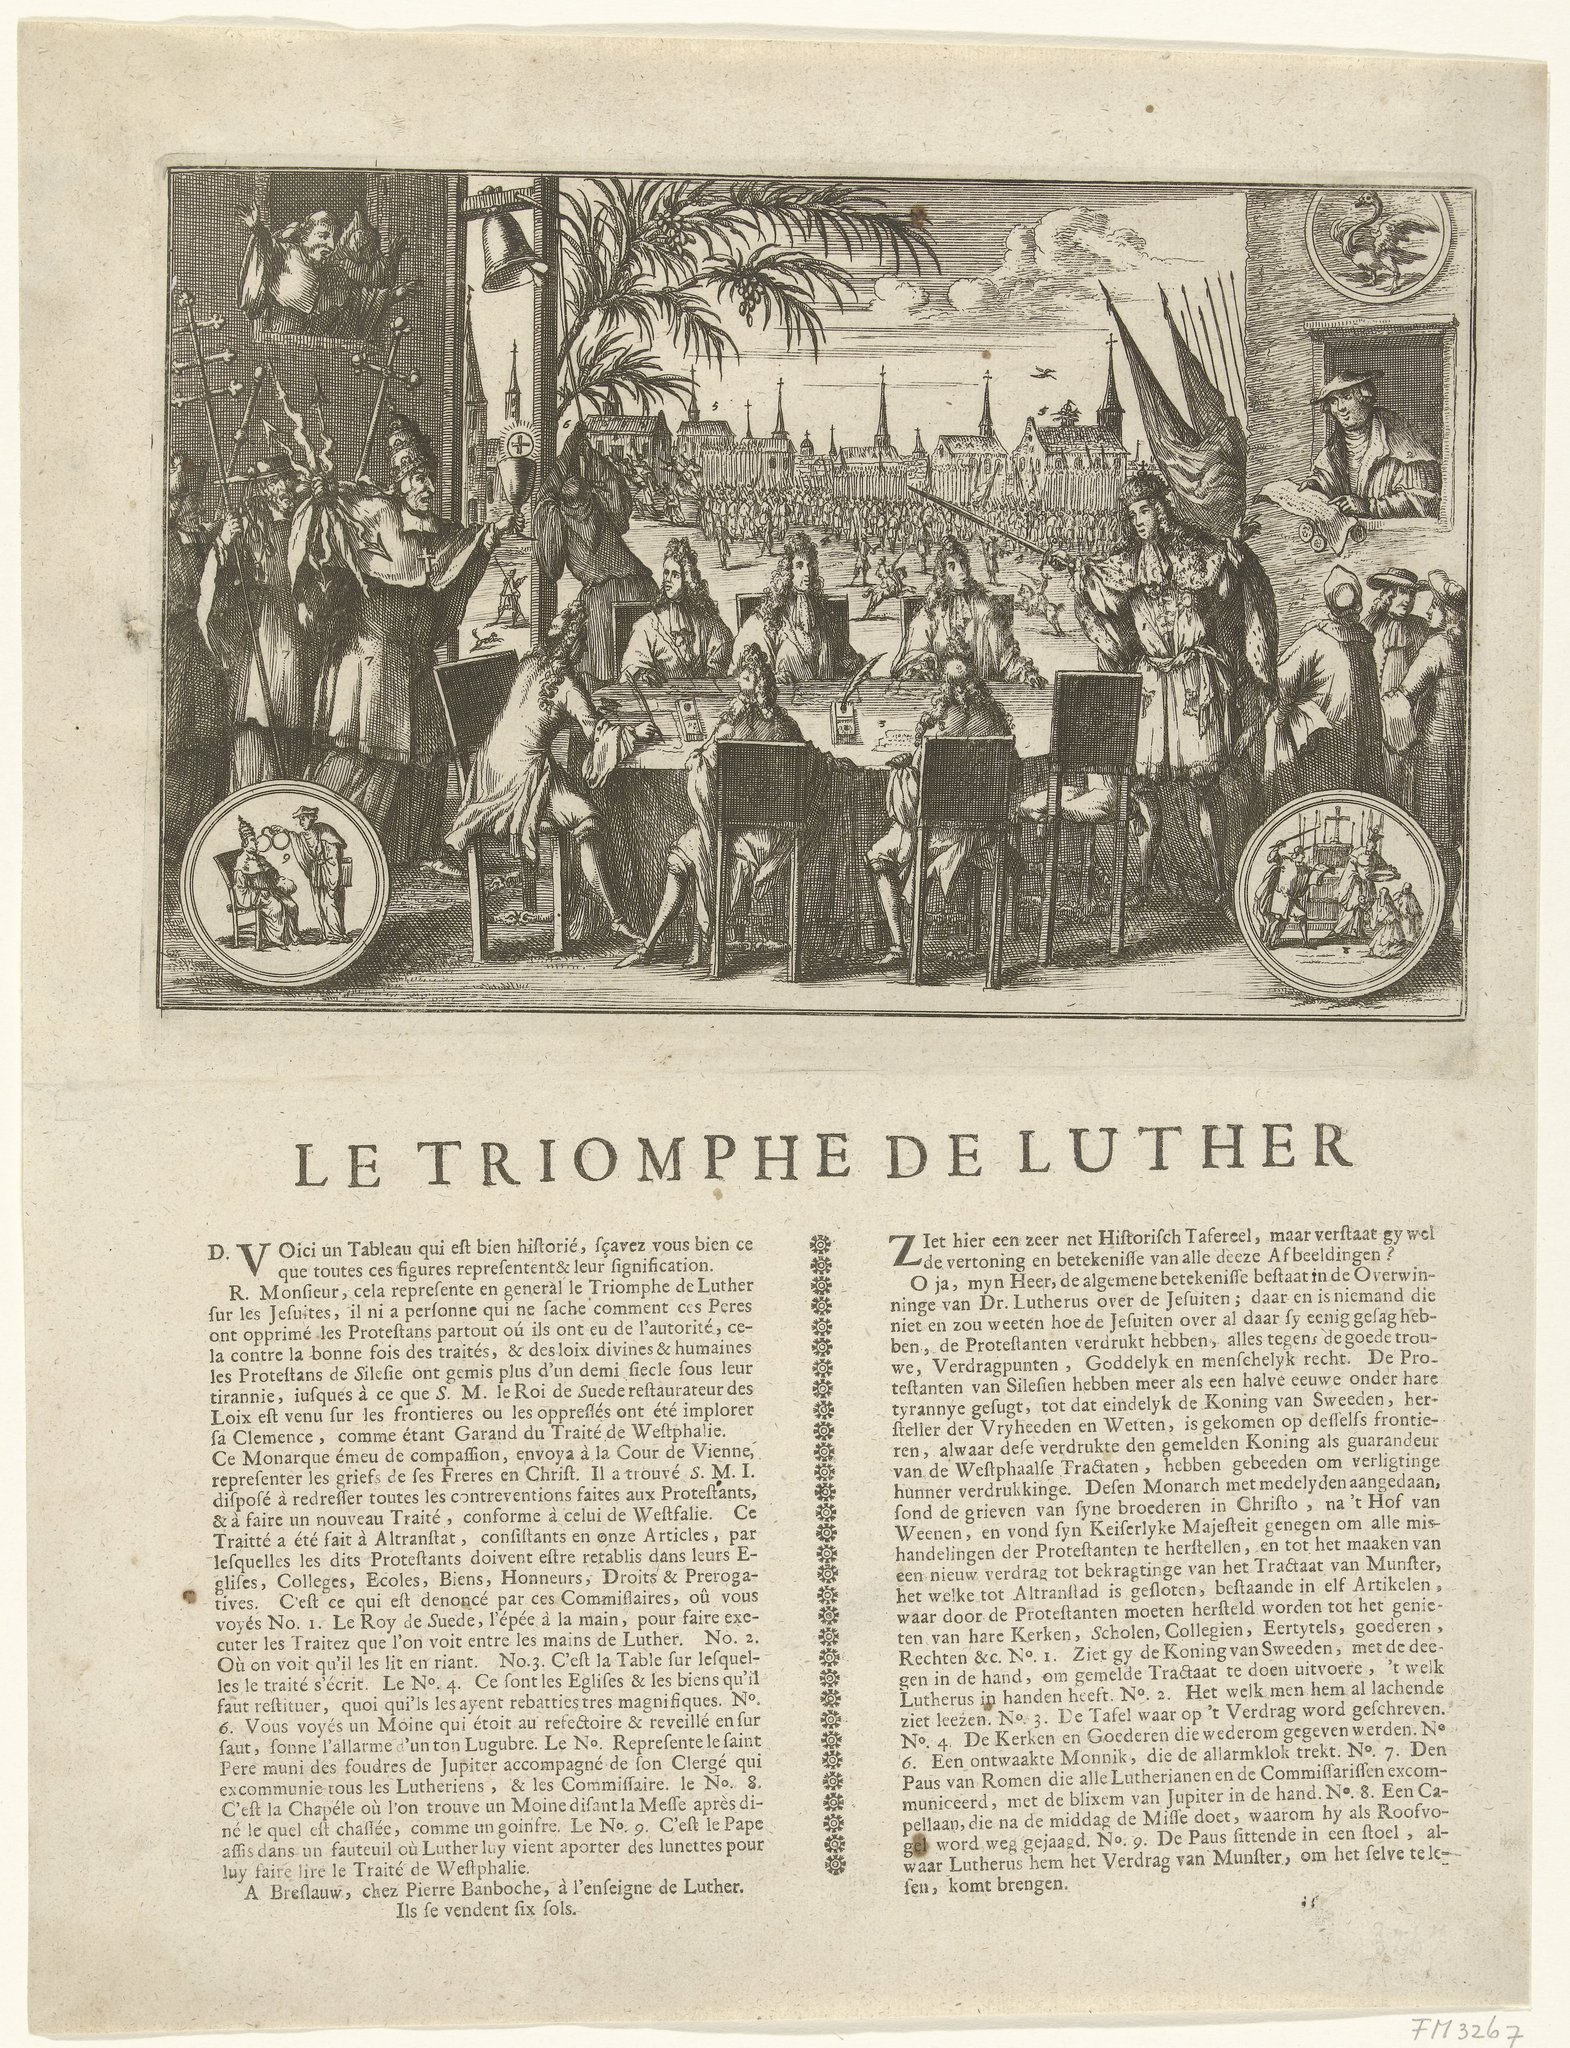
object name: cartoon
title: Triomf van Luther, ca. 1707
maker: Anonymous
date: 1707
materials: paper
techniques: etching, letterpress printing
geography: northern netherlands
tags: priest, martin luther, rome, clergyman, clemens xi, signing of peace treaty, concluding the peace, political caricatures and satires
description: Triomf van Luther, ca. 1707. Koning Karel XII van Zweden komt op voor het herstel van de rechten van de lutheranen volgens het verdrag van Altranstädt, 1707. De koning staat aan het hoofd van een tafel waaraan het verdrag getekend wordt en wijst met zijn zwaard naar een razende paus aan de linker kant van de tafel. Rechts kijkt Martin Luther vanuit een venster glimlachend toe. Onder de plaat 2 kolommen tekst in het Frans en Nederlands. Onderdeel van een groep afzonderlijke spotprenten op Lodewijk XIV tijdens de Spaanse Successieoorlog, ca. 1701-1713.